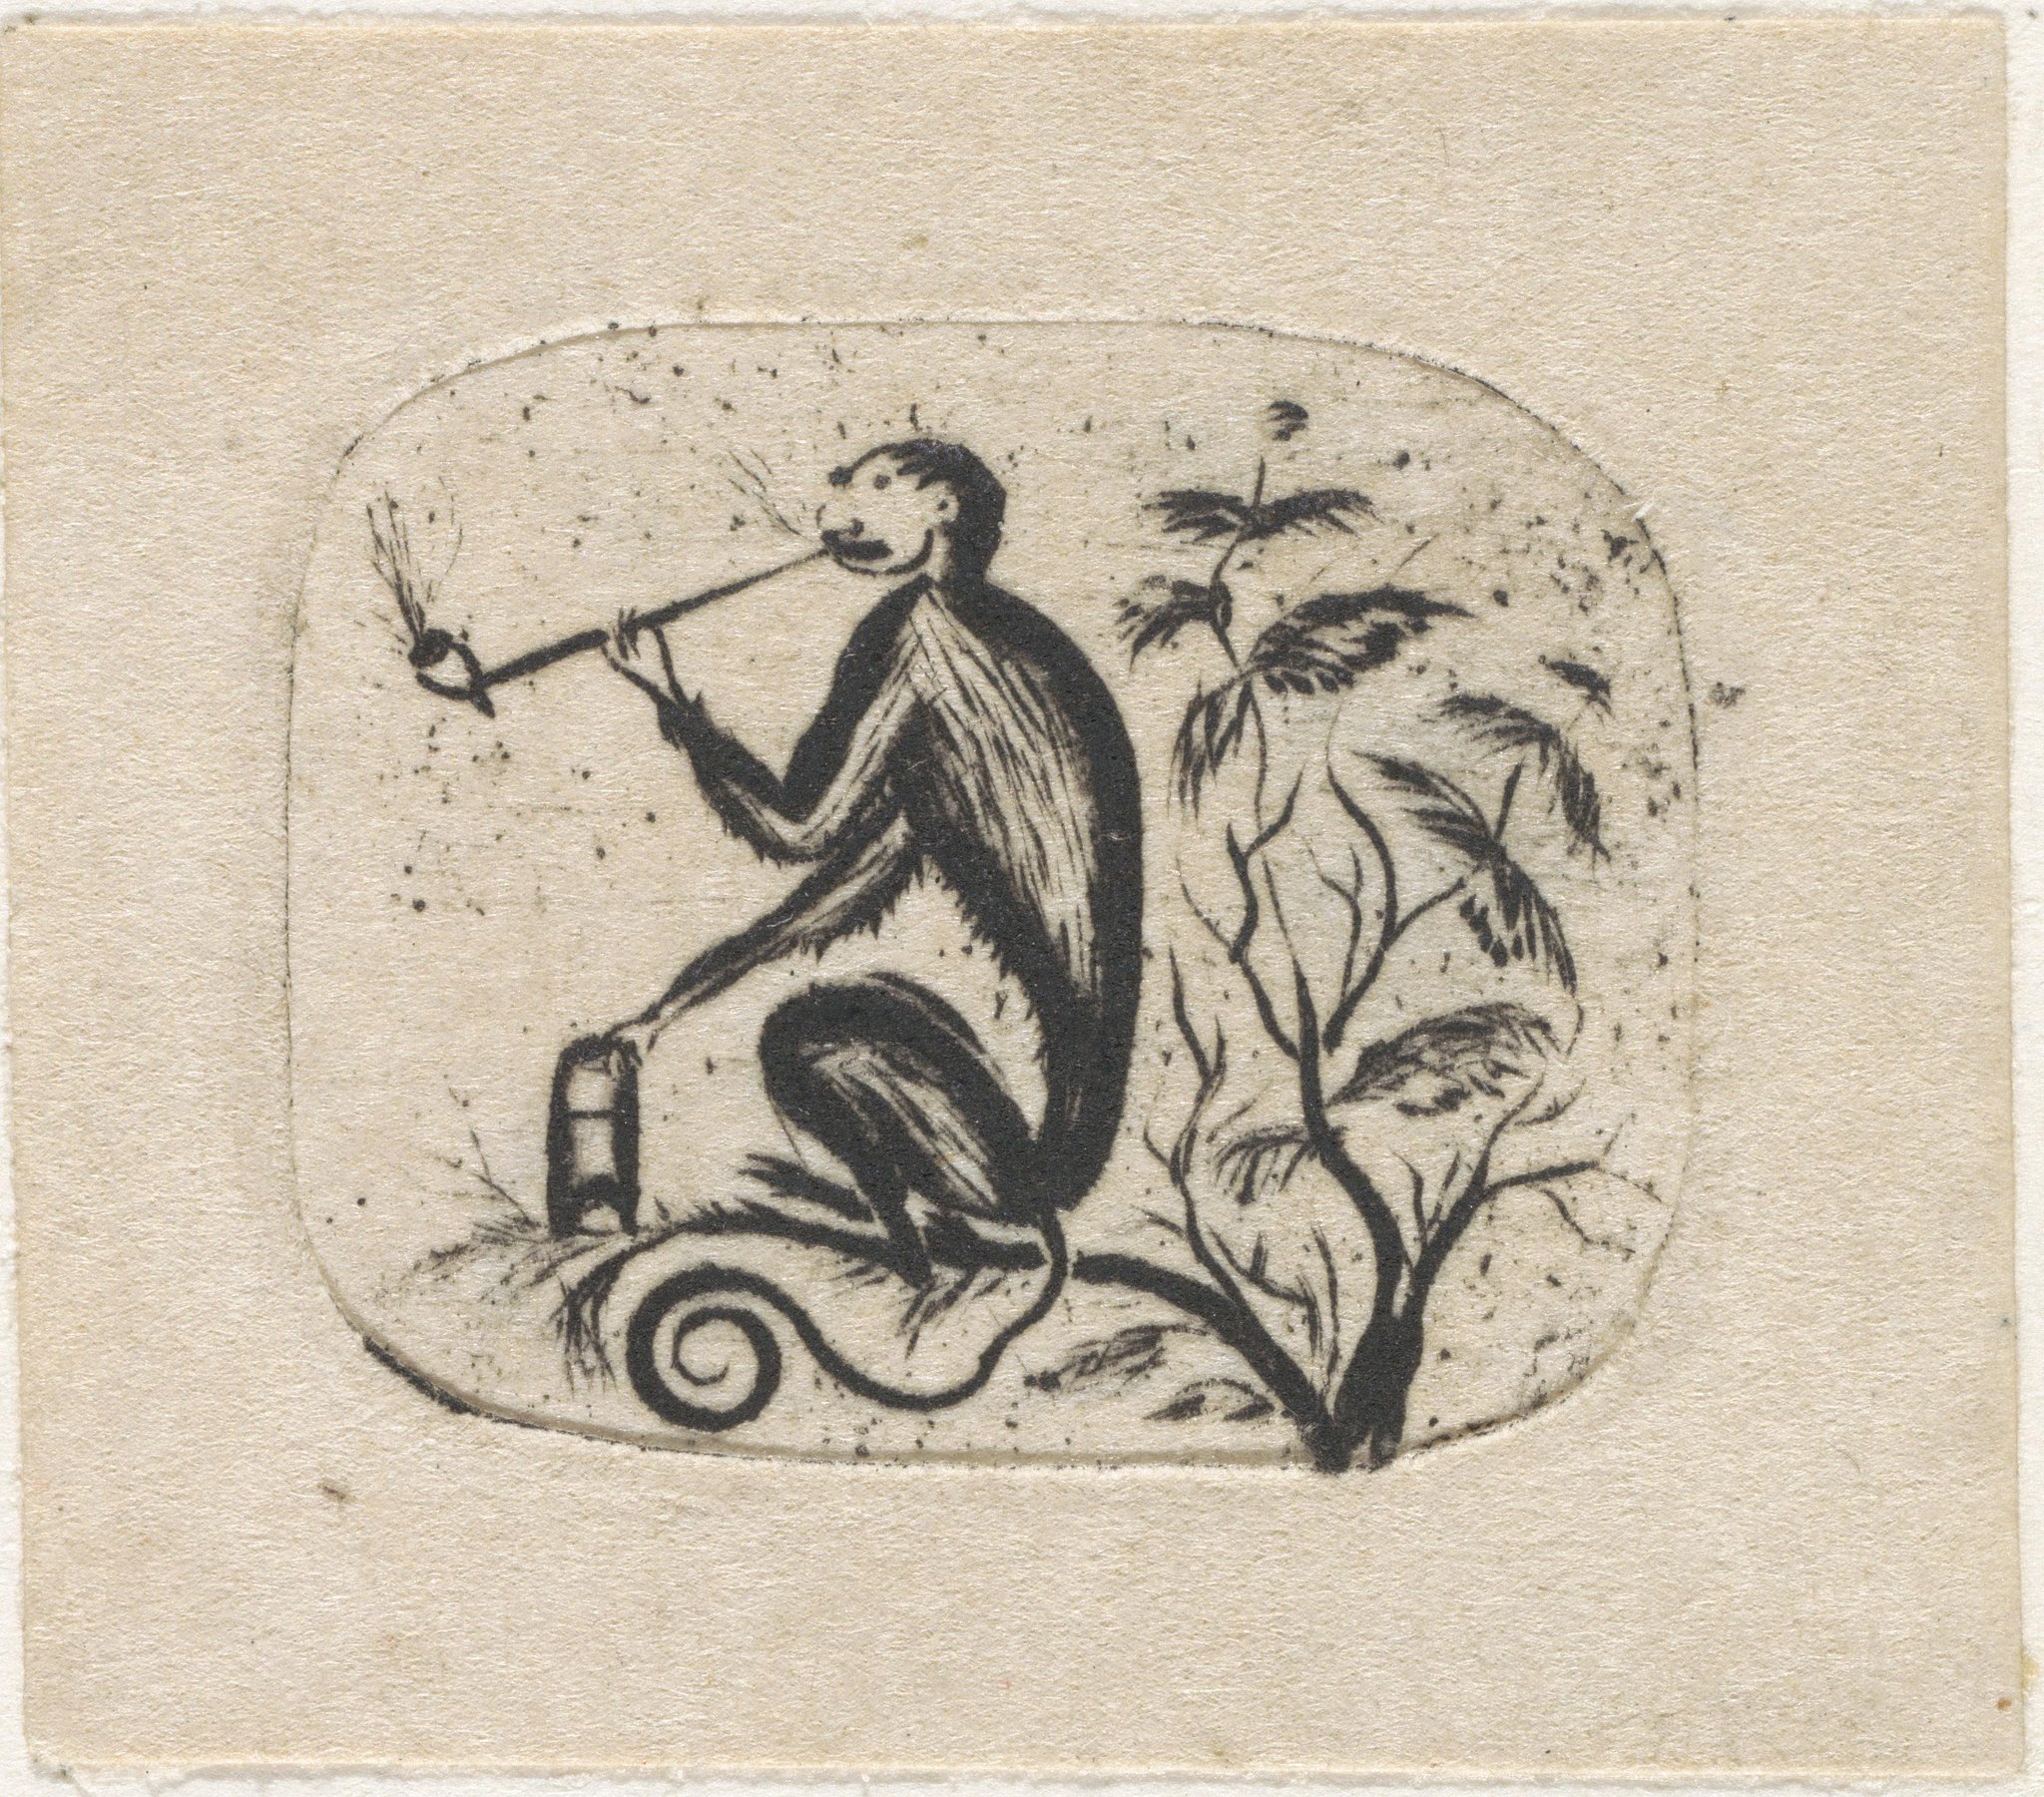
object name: ornament print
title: Pijprokende aap op tak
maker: isaac walraven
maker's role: draughtsman, painter, print maker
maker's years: 1686-1765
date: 1696-1765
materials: paper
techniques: engraving, etching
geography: amsterdam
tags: monkeys, apes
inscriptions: collector's mark: Lugt 2760, collector's mark: Lugt 2228